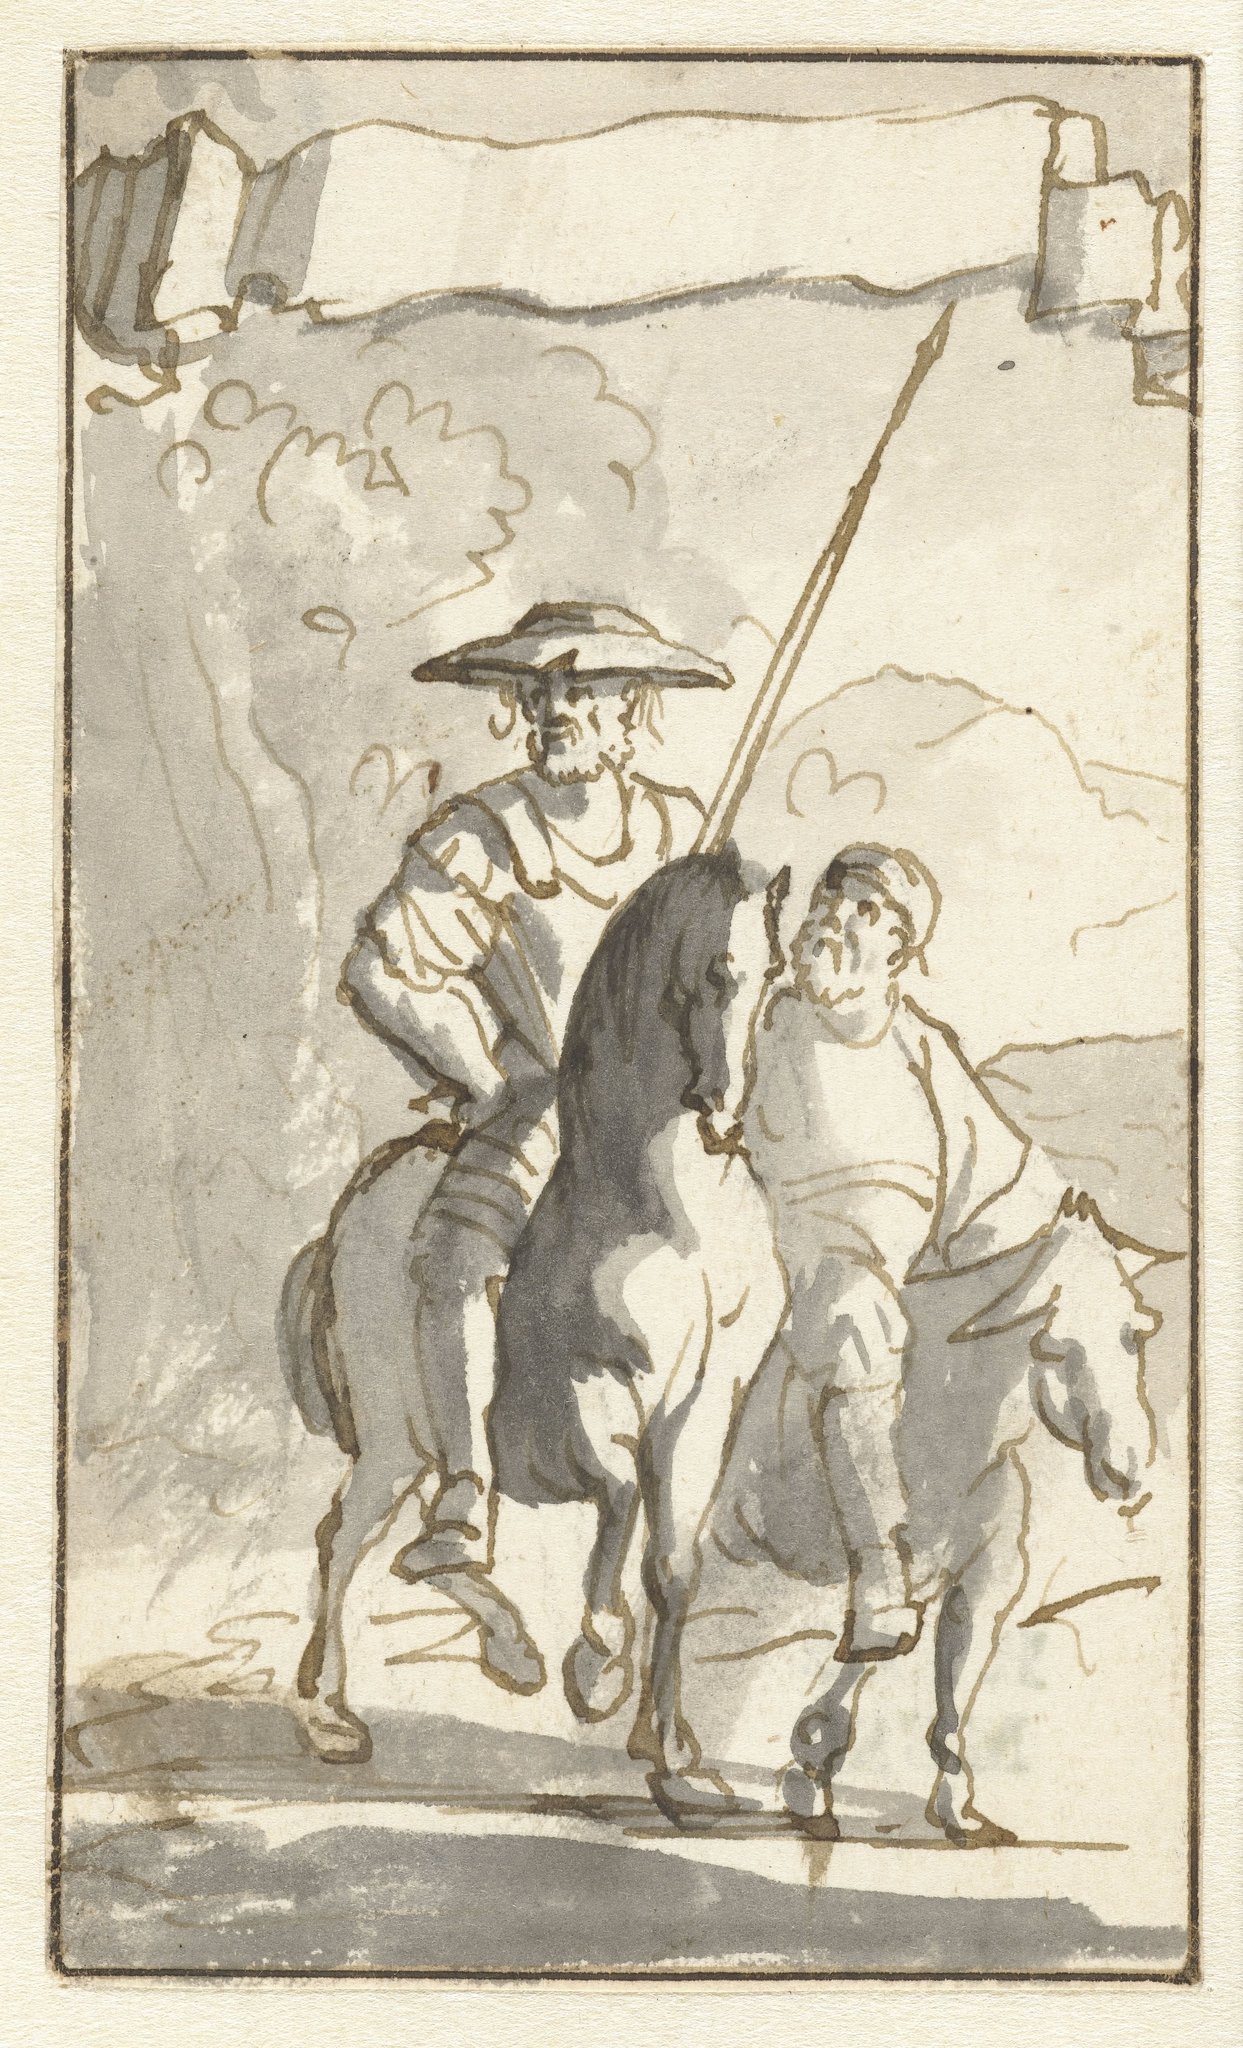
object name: design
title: Ontwerpen voor het vijfde deel van Histoire de l'admirable Don Quixotte (...)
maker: caspar luyken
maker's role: draughtsman, print maker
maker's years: 1672-1708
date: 1694-1696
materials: ink, paper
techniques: brush, pen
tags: riding a horse, ass, or mule; rider, horseman, don quixote, sancho panza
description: Ontwerp voor illustratie in het vijfde deel van Cervantes' Histoire de l'admirable Don Quixotte de la Manche.